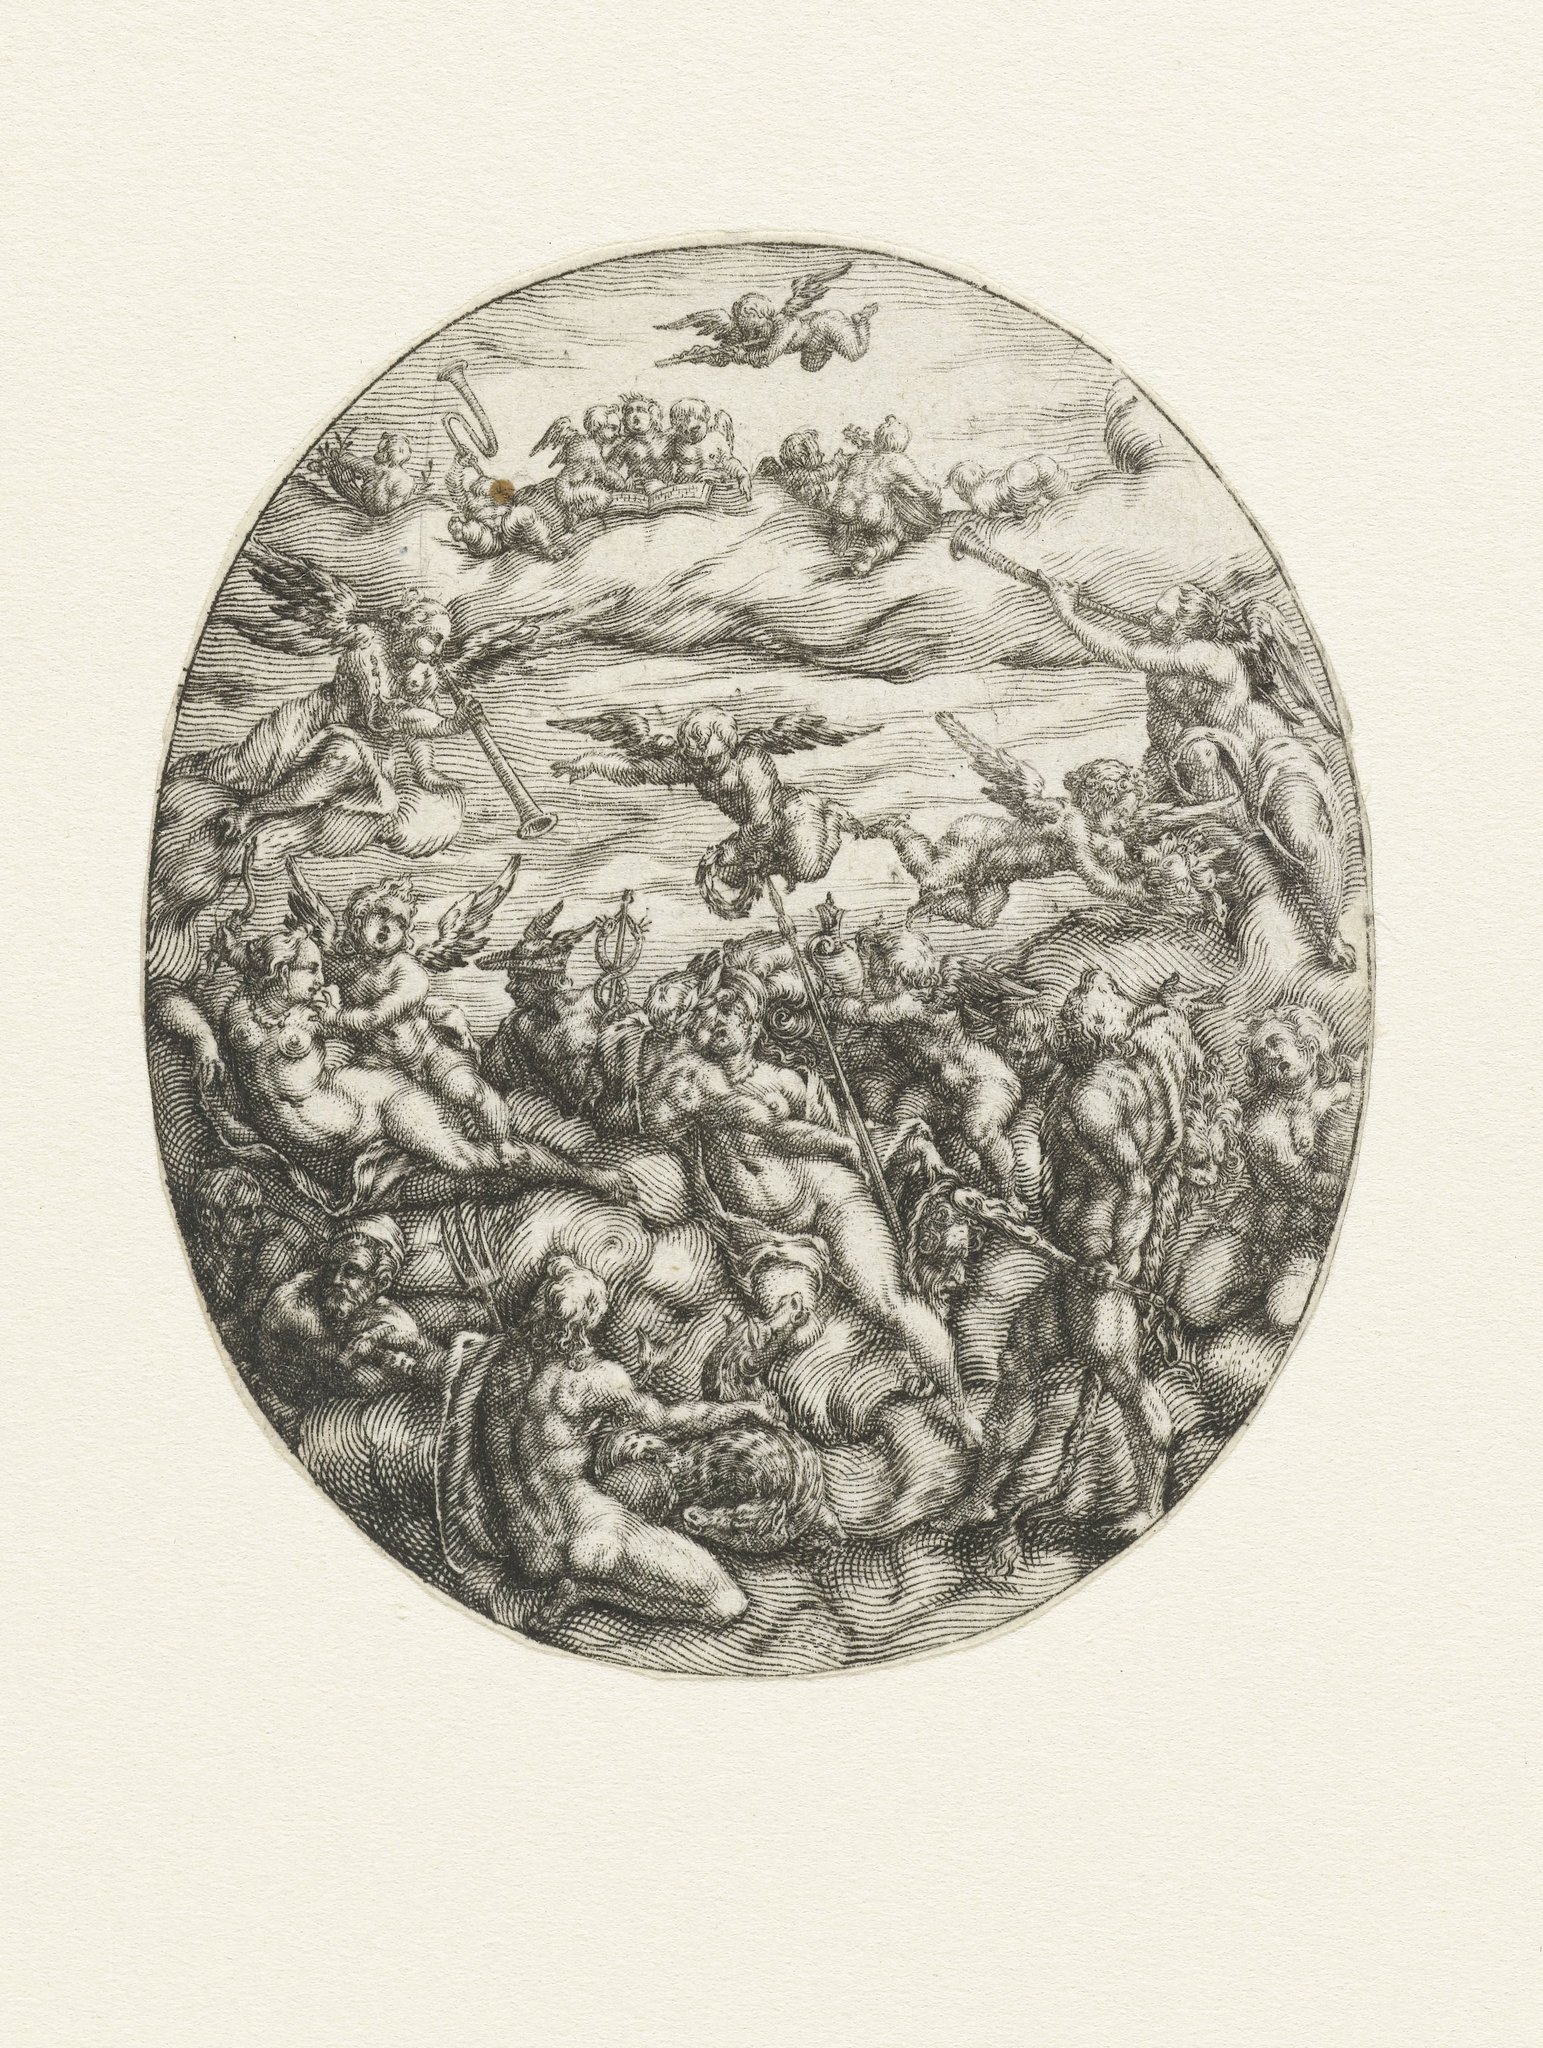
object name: print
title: Ovaal met de Olympische goden in de wolken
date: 1608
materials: paper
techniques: engraving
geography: amsterdam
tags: the olympian gods together: jupiter, juno, neptune, ceres, apollo, diana, mars, venus, mercury, minerva, vulcan, vesta (or bacchus), more than one musician with instrument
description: Van links naar rechts: Venus en Amor, Vulcan, Mercurius, Neptunus, Minerva en Hercules. Bovenaan musicerende putti. Blad uit serie bestaande uit een titelblad en 11 bladen met ontwerpen voor horlogedeksels.